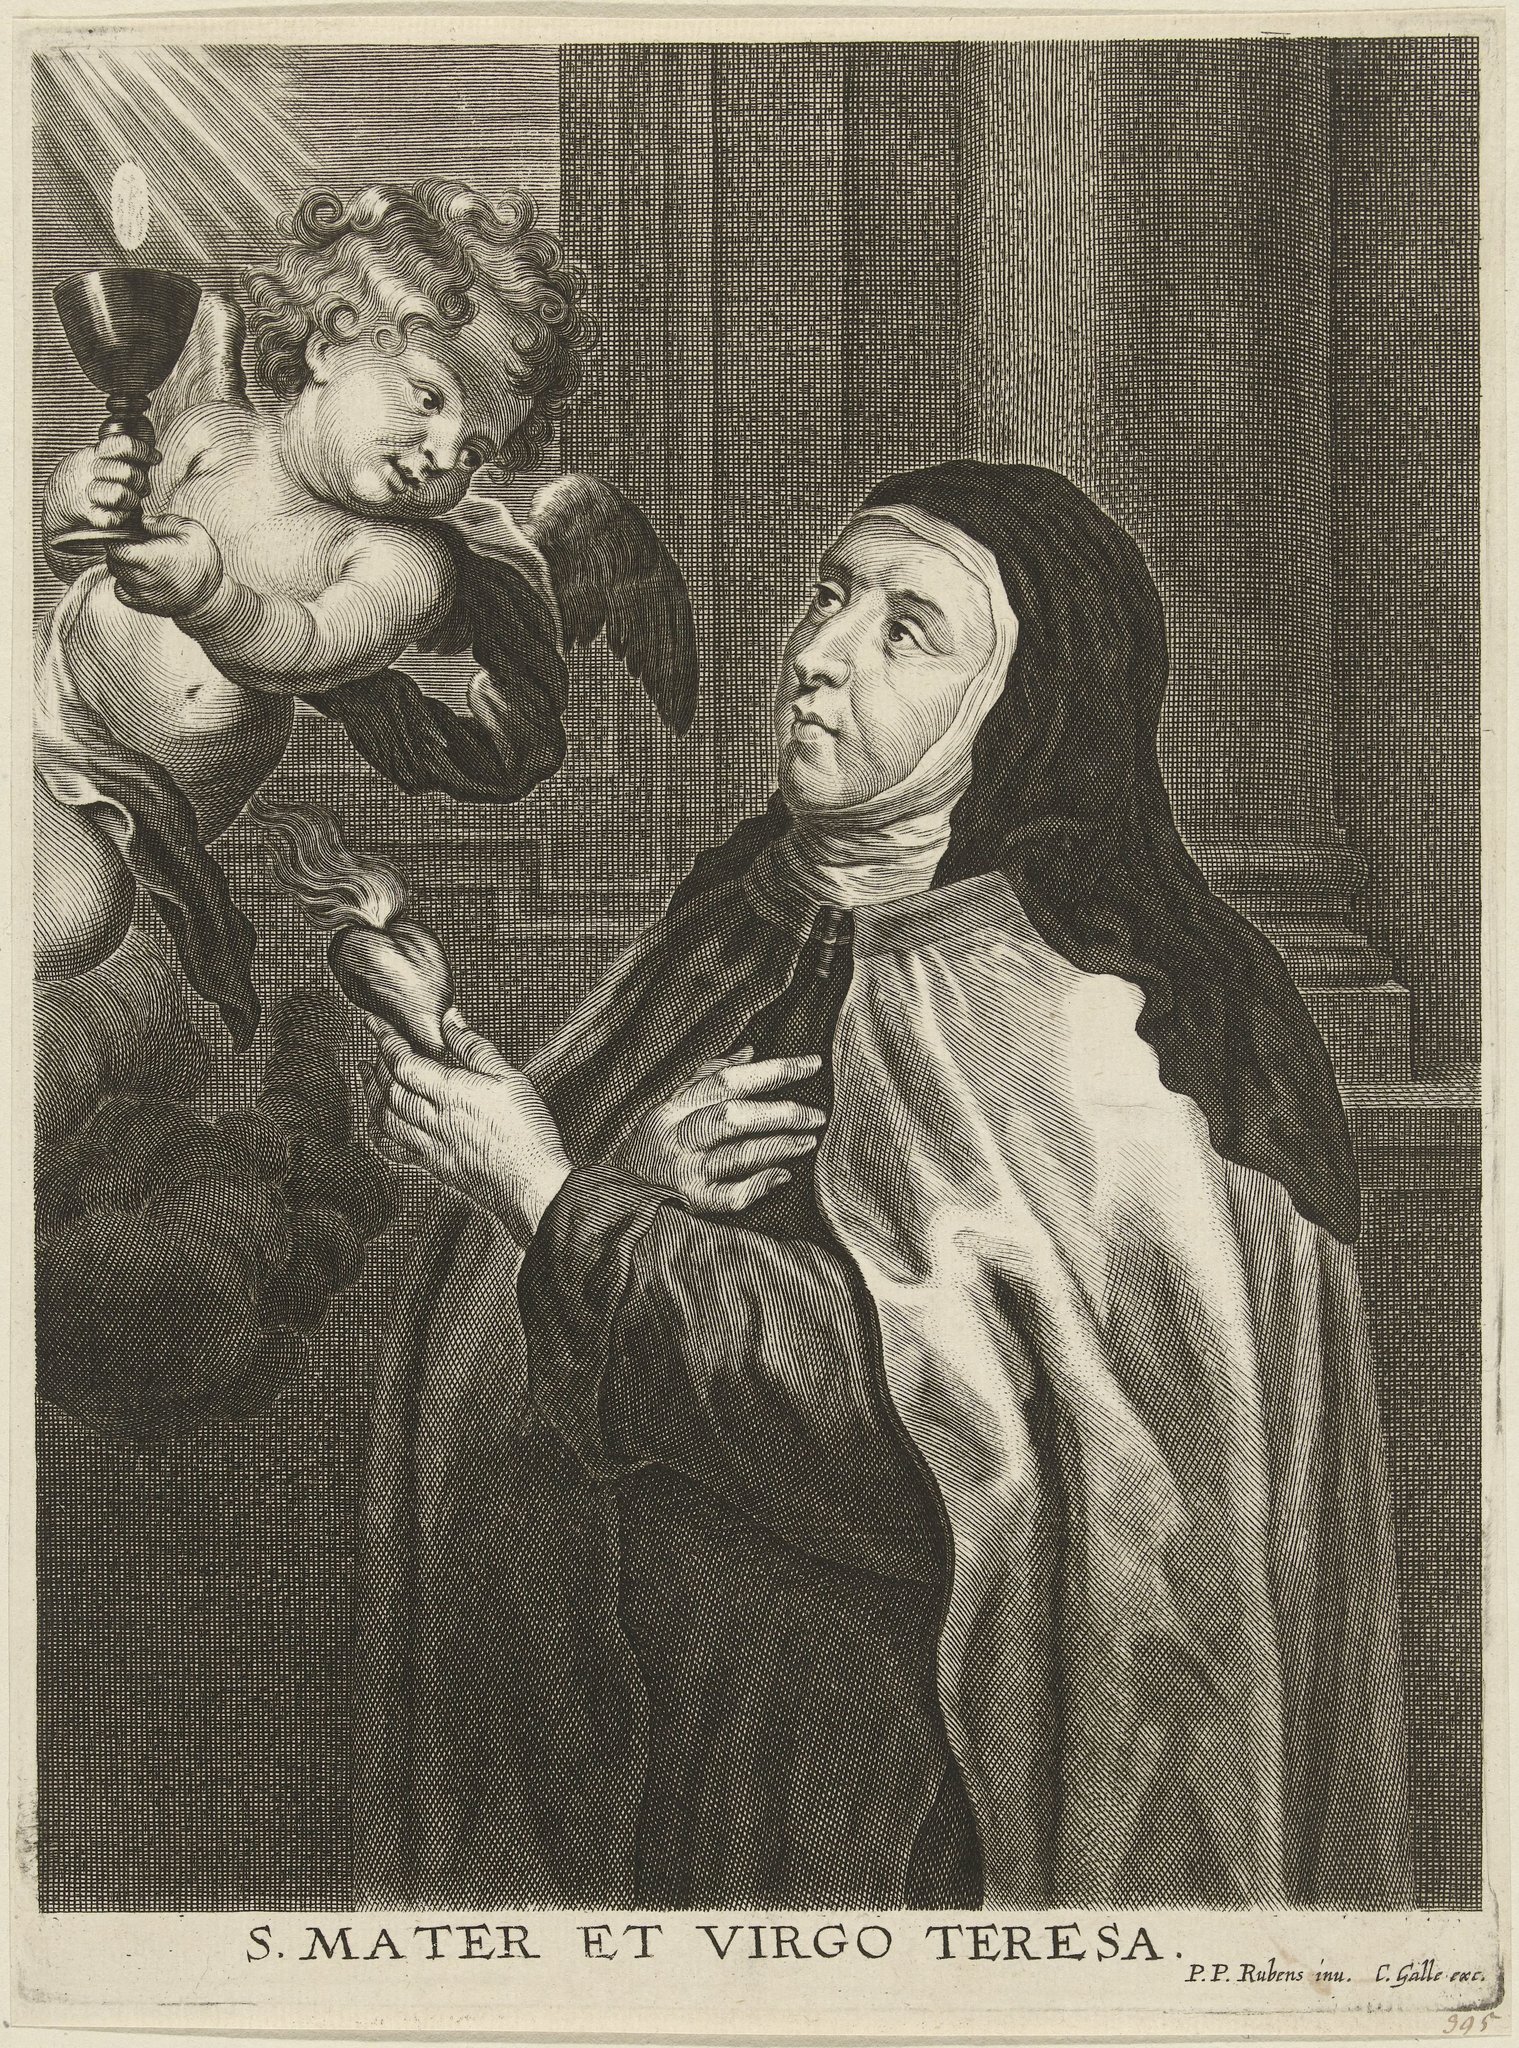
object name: print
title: Heilige Theresia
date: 1641-1678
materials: paper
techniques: engraving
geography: antwerp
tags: the foundress of the reformed (discalced) carmelites, t(h)eres(i)a of avila; possible attributes: angel, arrow, dove, heart (flaming or pierced by an arrow), angel(s) with chalice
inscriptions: collector's mark: Lugt 240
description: De heilige Theresia in het habijt van de karmelietessen. Een engel brengt haar een kelk met hostie. Theresia houdt een brandend hart in haar hand.